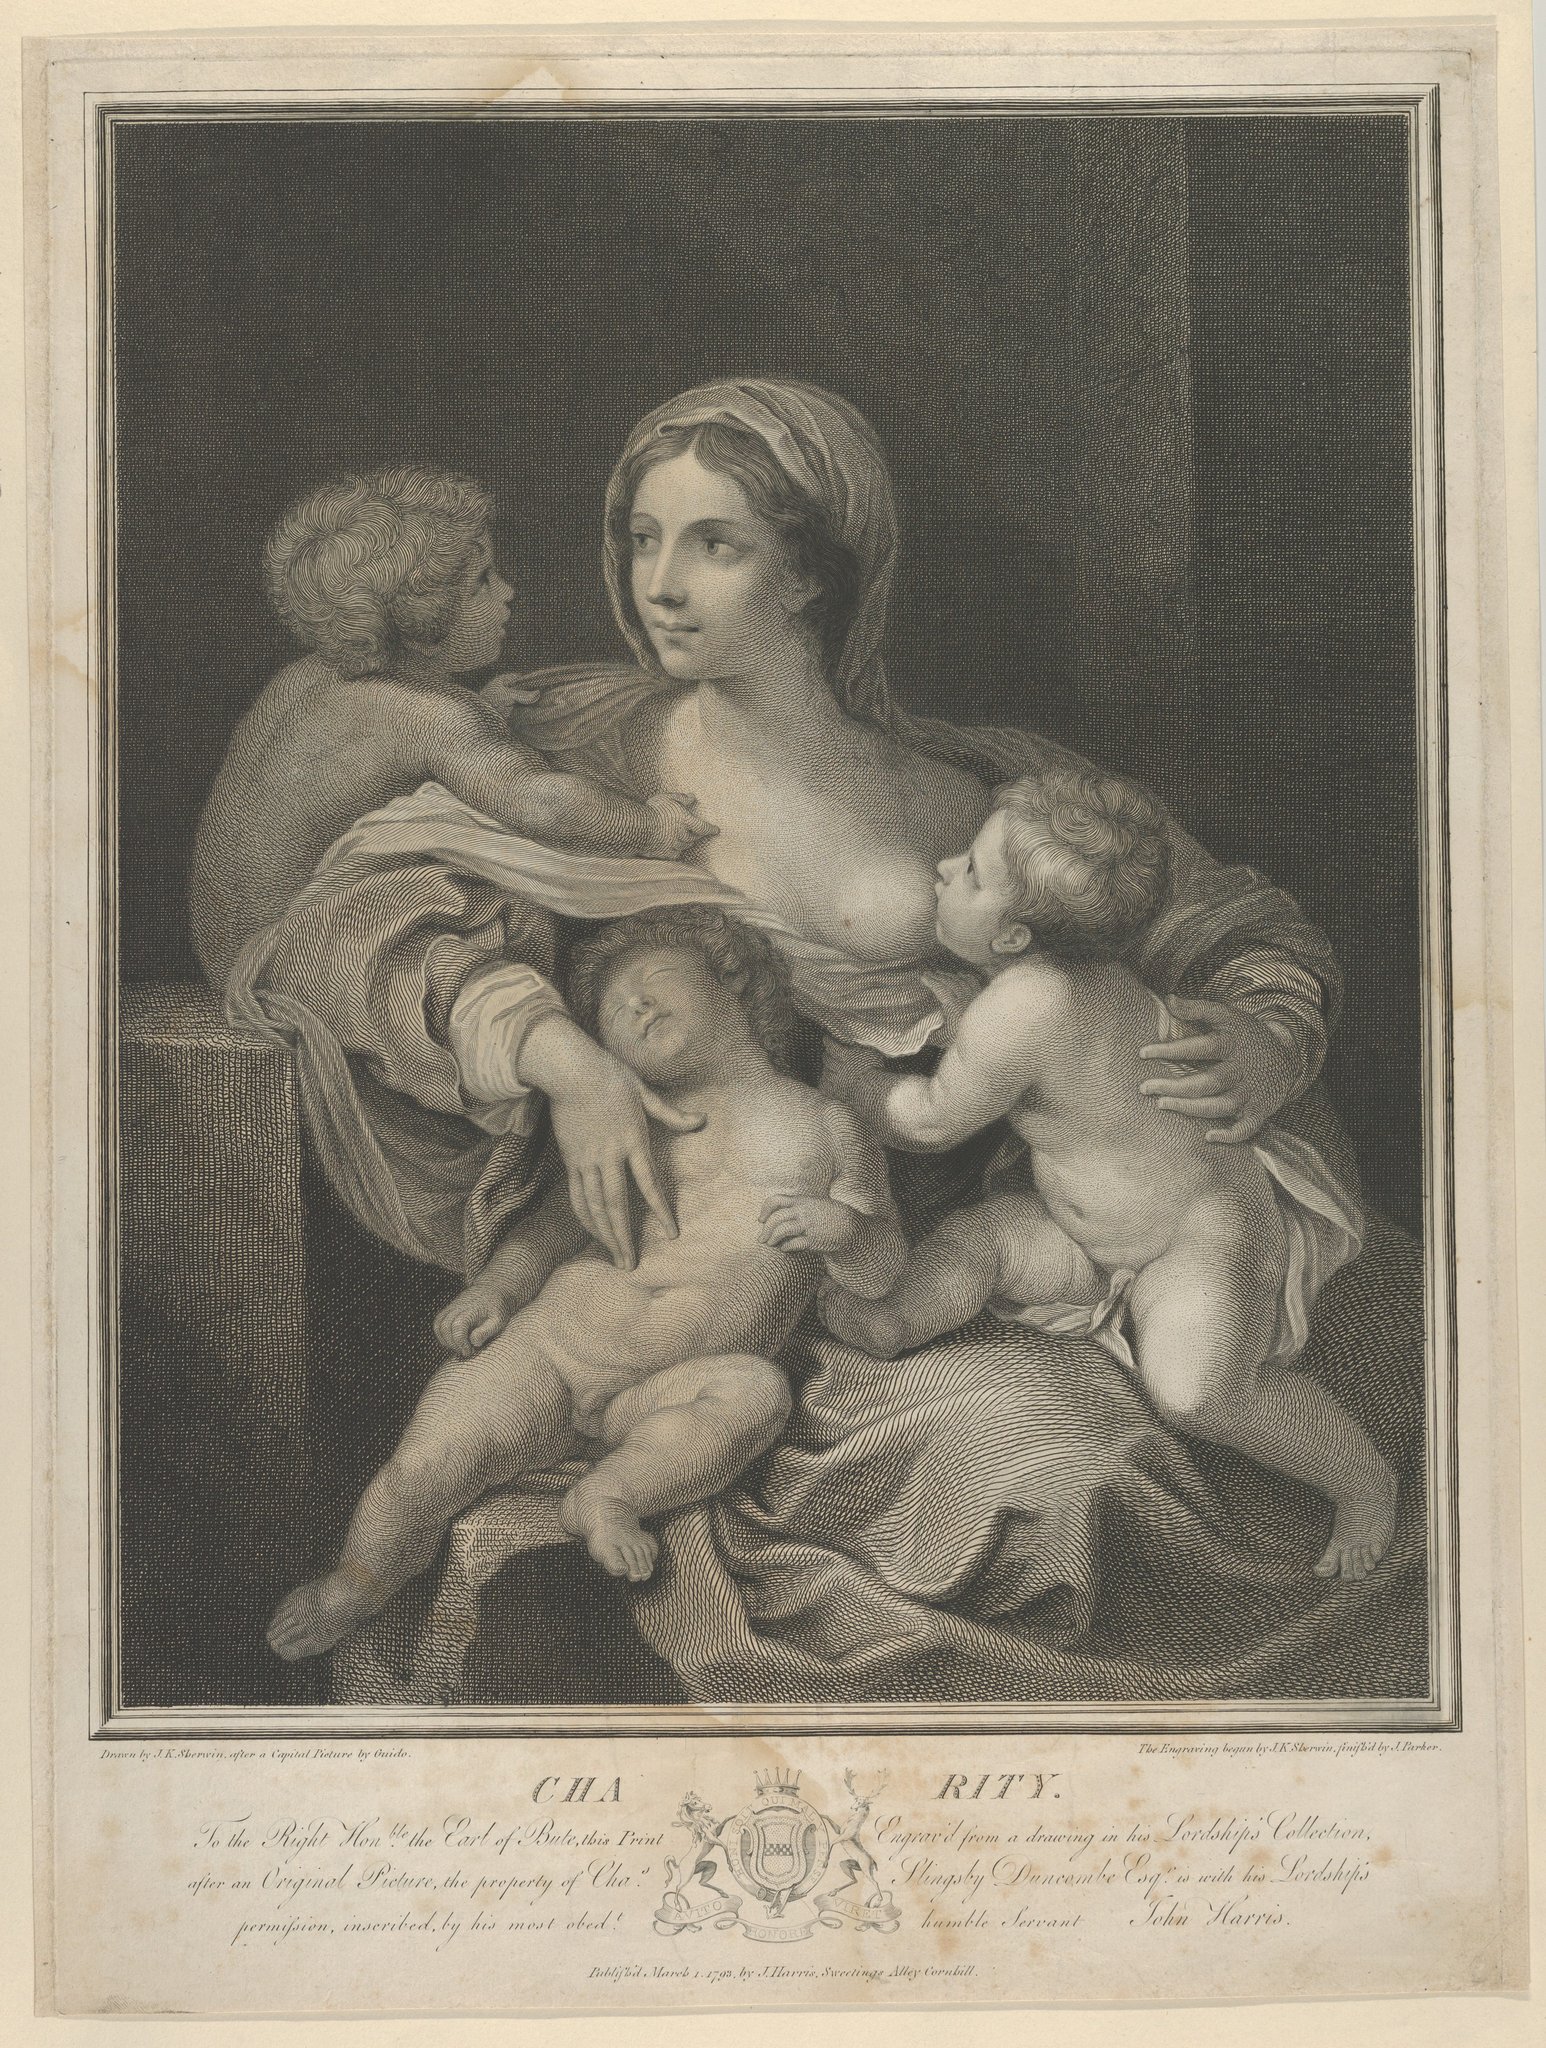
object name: print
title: Charity seated nursing an infant, another sleeping on her lap and a third talking to her, after Reni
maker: john keyse sherwin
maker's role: engraver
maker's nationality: british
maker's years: 1751-1790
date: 1793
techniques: engraving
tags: sleeping,infants,female nudes,nursing